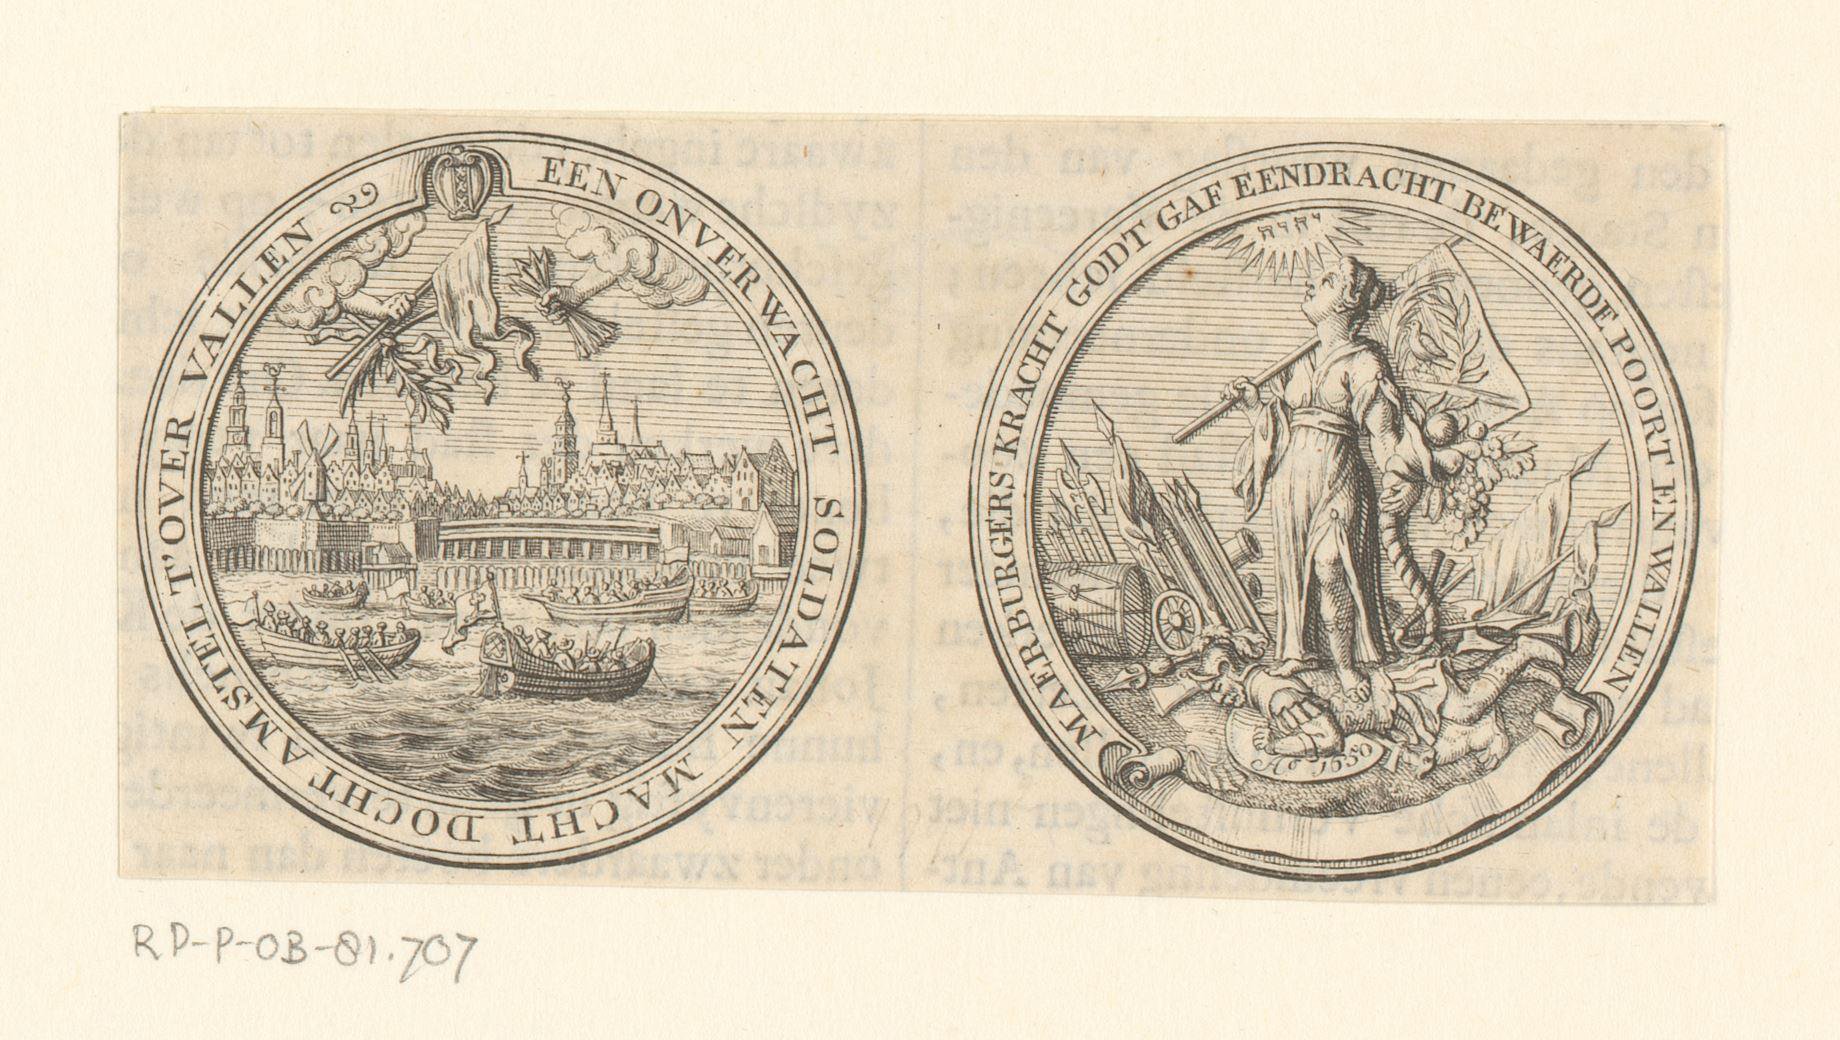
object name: historical object representation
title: Penning op het beleg van Amsterdam door Willem II, 1650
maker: Anonymous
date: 1724-1726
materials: paper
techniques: etching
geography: northern netherlands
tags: william ii (prince of orange), medal (considered as a piece of sculpture, regardless of its specific function), amsterdam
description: Penning over de gebeurtenissen te Amsterdam in het jaar 1650. Voorzijde: gezicht op Amsterdam en schepen op de Amstel, daarboven handen uit de wolken met pijlenbundel, vaandel en palmtak. Keerzijde: de Vrede staande op wapentuig. Uitgeknipte illustratie bedrukt met tekst op achterzijde.